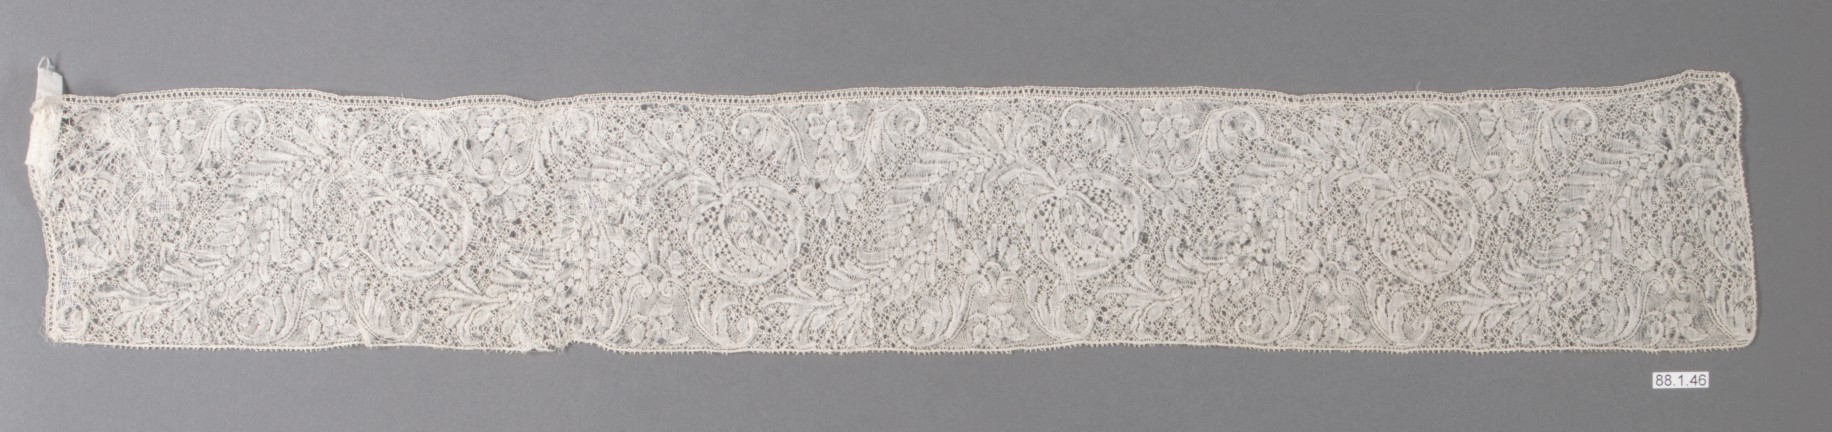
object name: insertion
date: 1667-1733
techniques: lace